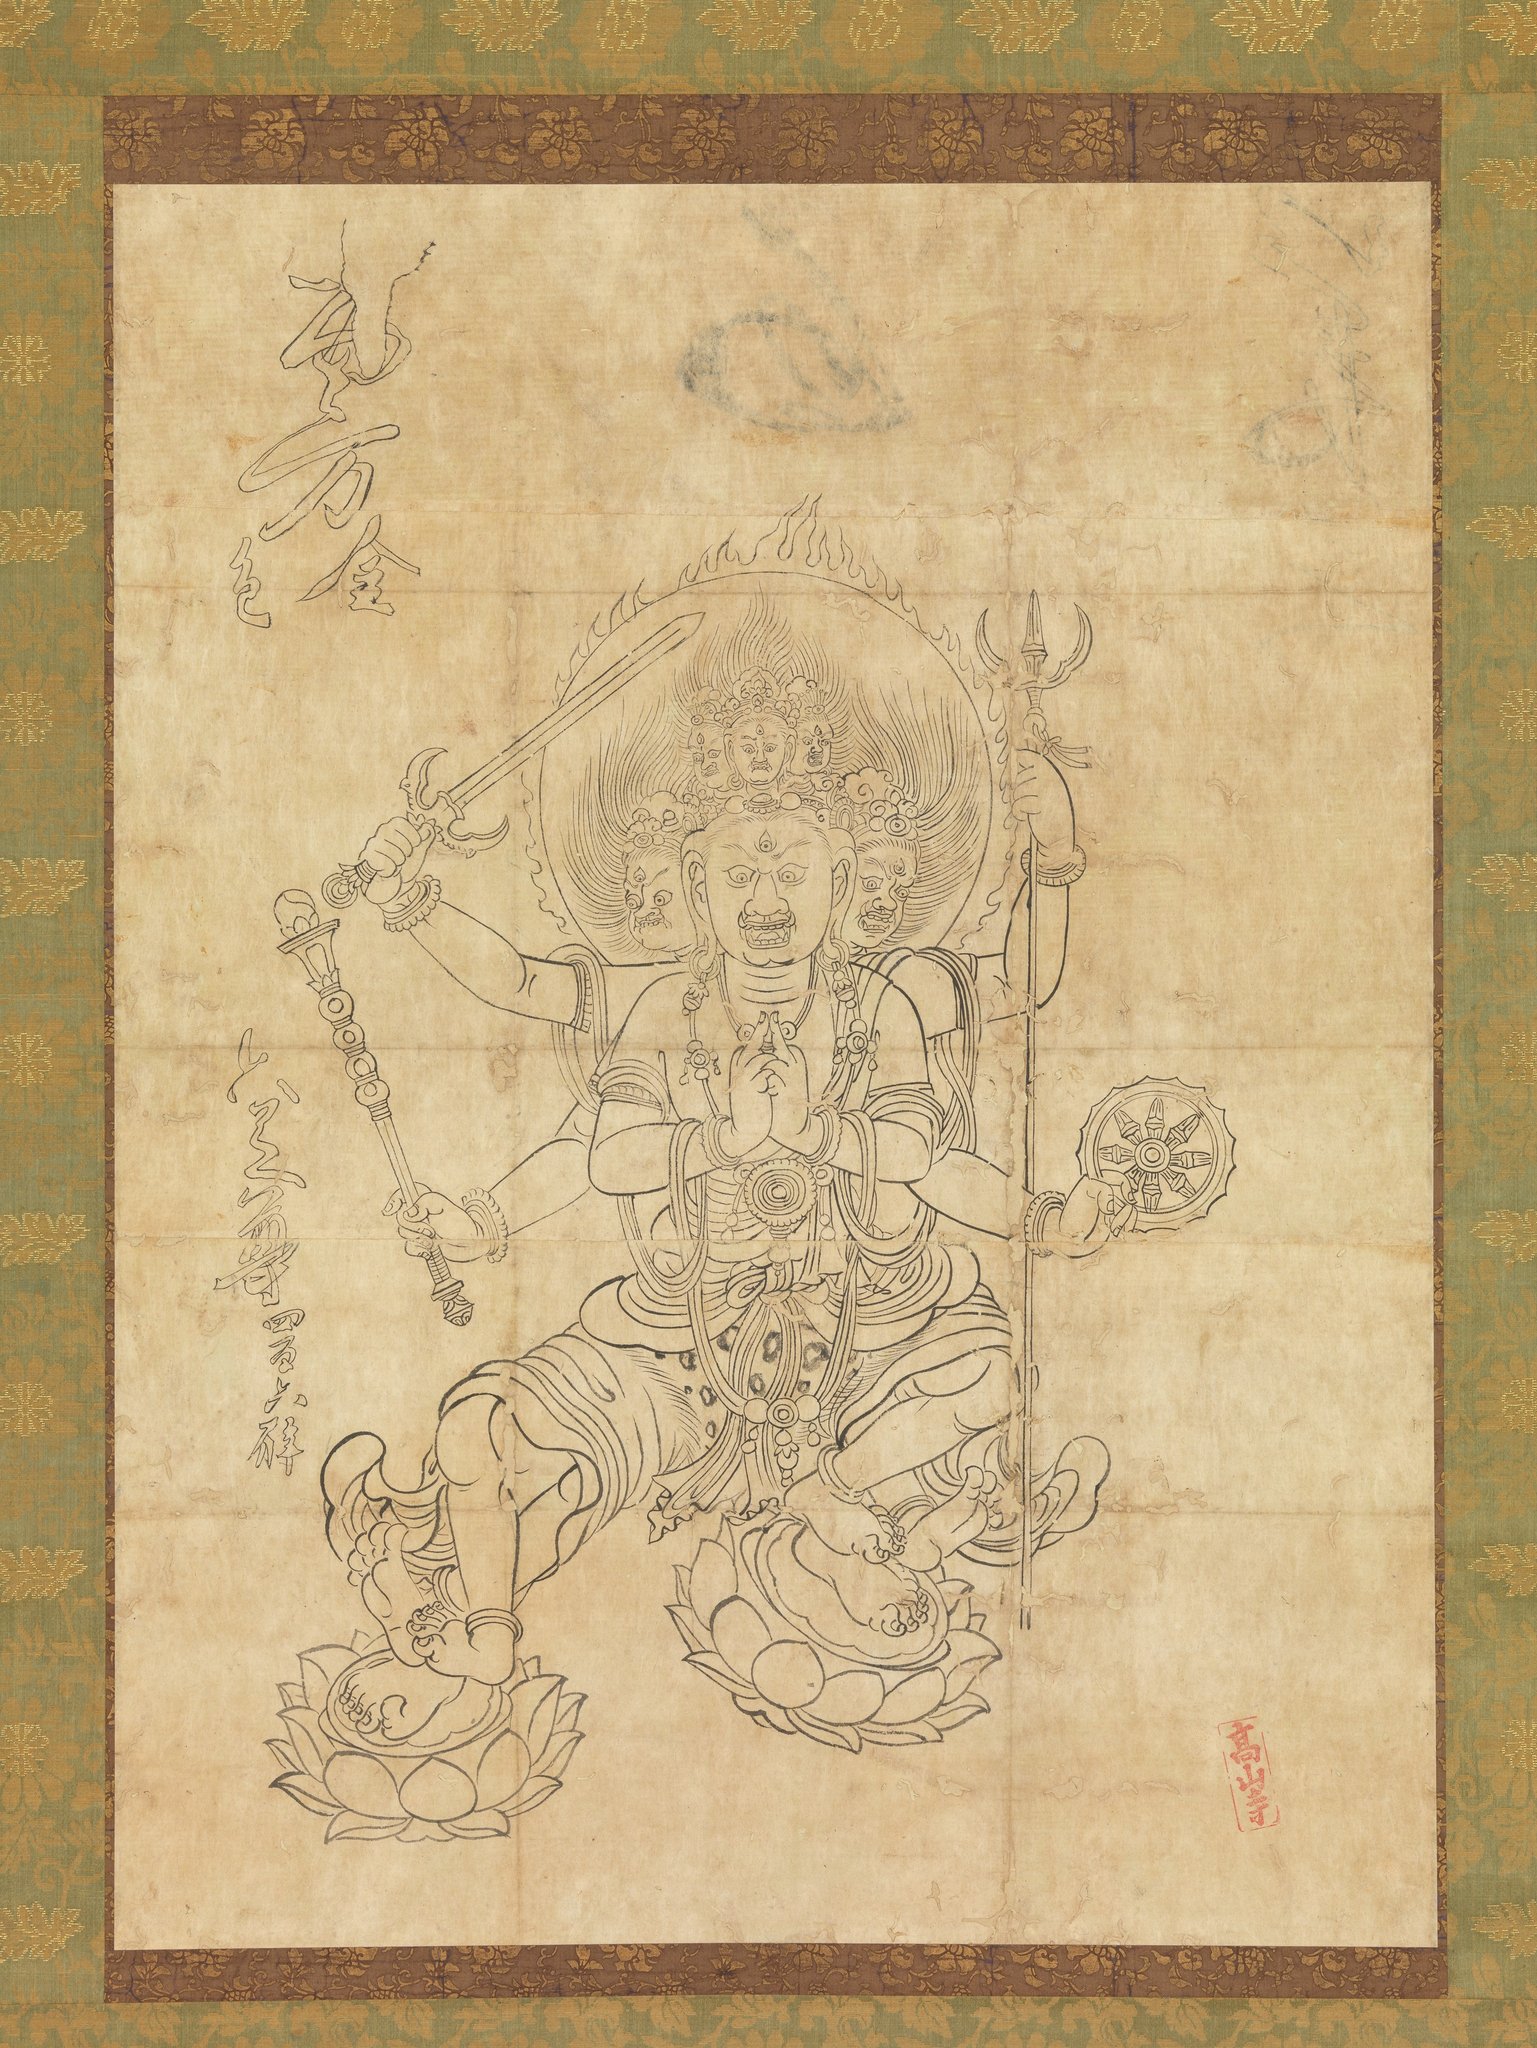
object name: hanging scroll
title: Iconographic Drawing of the Wisdom King Daiitoku (Daiitoku Myōō)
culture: japanese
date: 1101-1200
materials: ink, paper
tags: swords,kings,men,buddhism